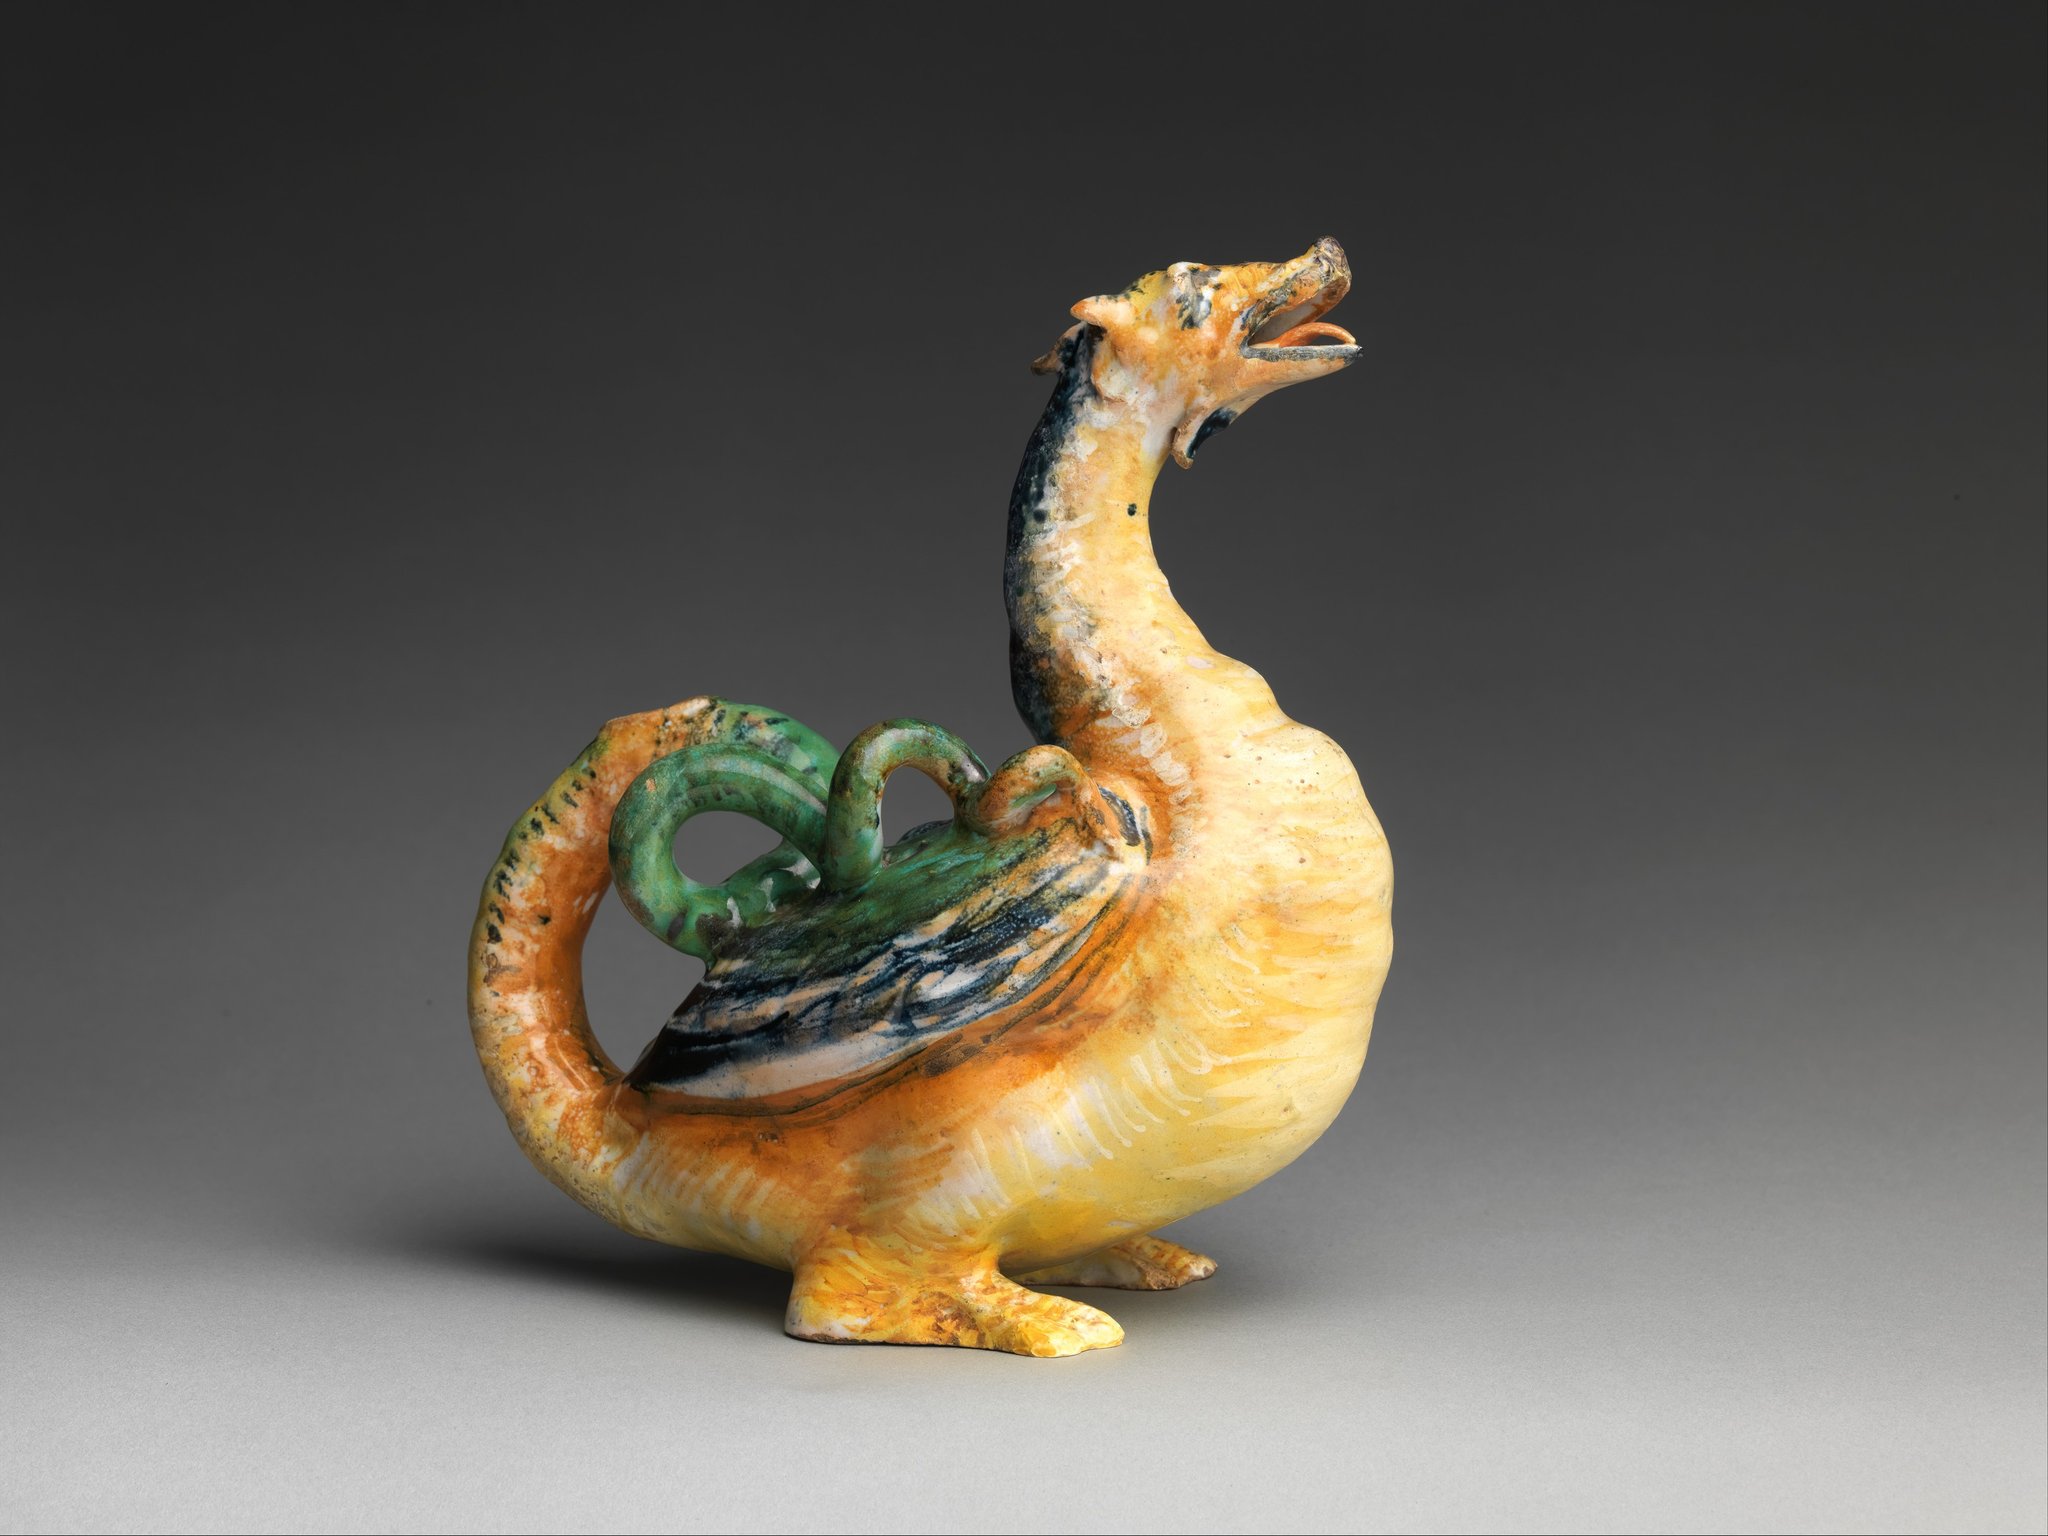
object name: ewer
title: Ewer in the form of a dragon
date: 1600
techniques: maiolica, glazing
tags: dragons